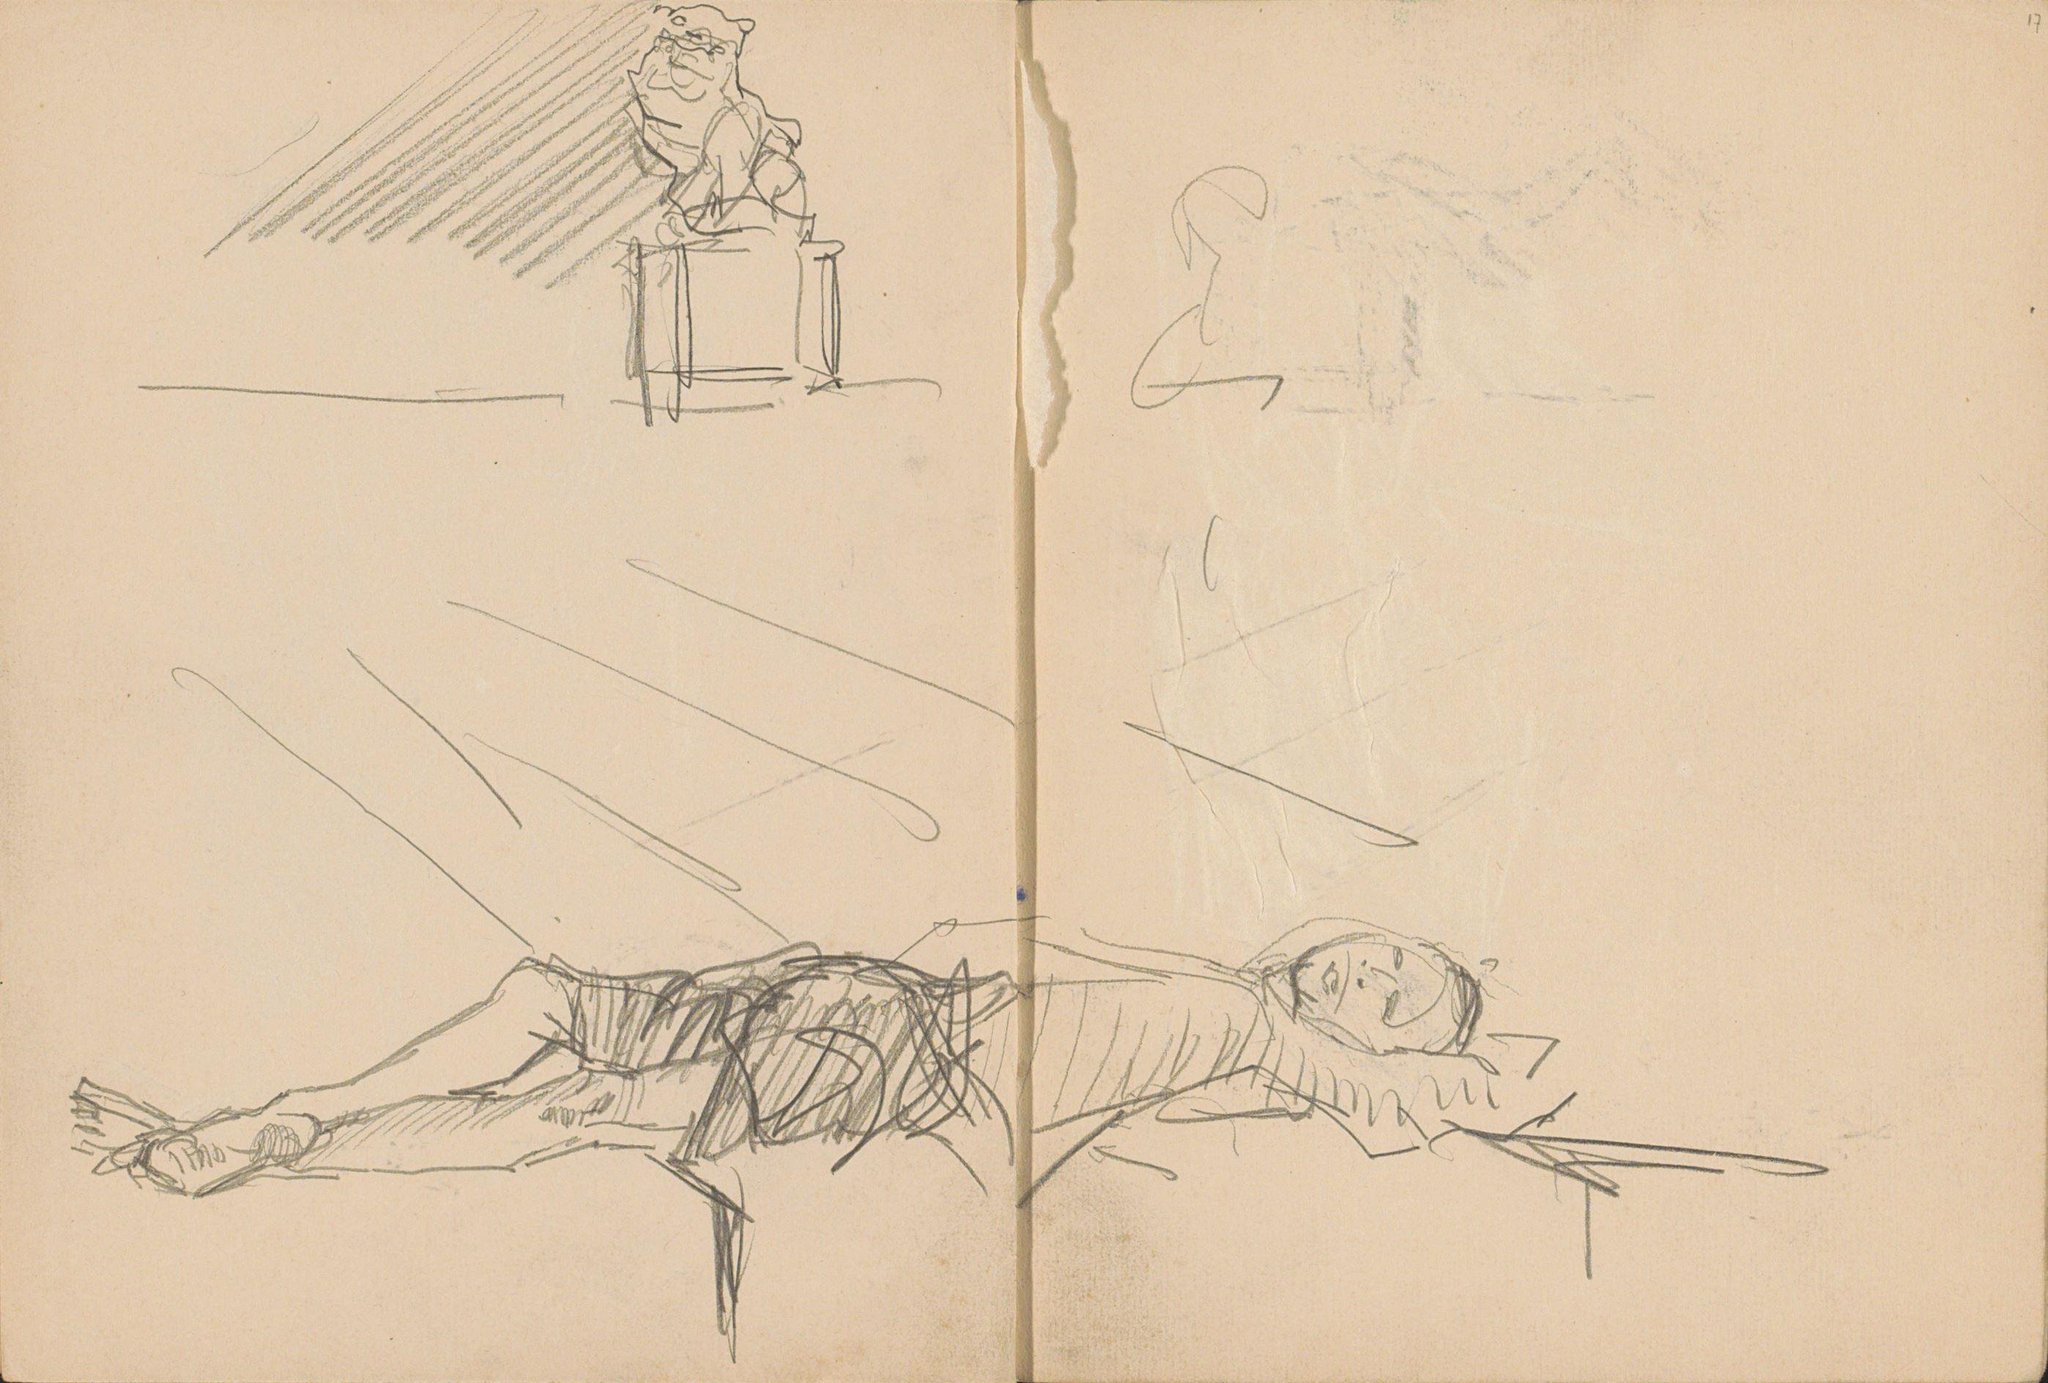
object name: sketchbook leaf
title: Liggende man op de grond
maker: isaac israels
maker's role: draughtsman, painter, print maker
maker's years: 1865-1934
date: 1921-1922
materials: paper, pencil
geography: dutch east indies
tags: asiatic races and peoples, adult man (+ lying), sculpture, dutch east indies, the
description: Op de achtergrond mogelijk een sculptuur. Indische figuurstudie. Pagina 16 en pagina 17 uit schetsboek XXXIV met 24 pagina's.